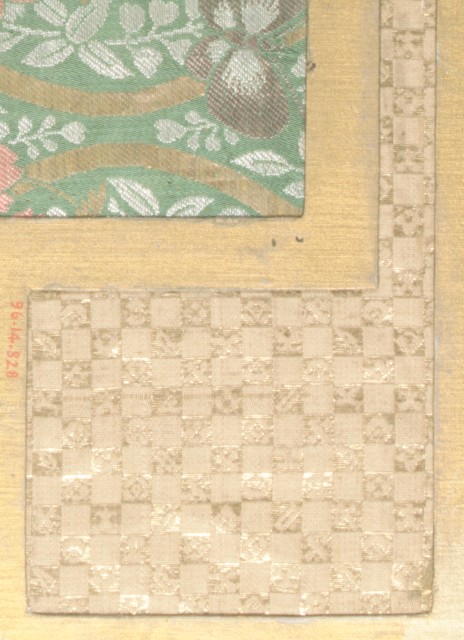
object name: piece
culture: japanese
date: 1701-1900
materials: silk